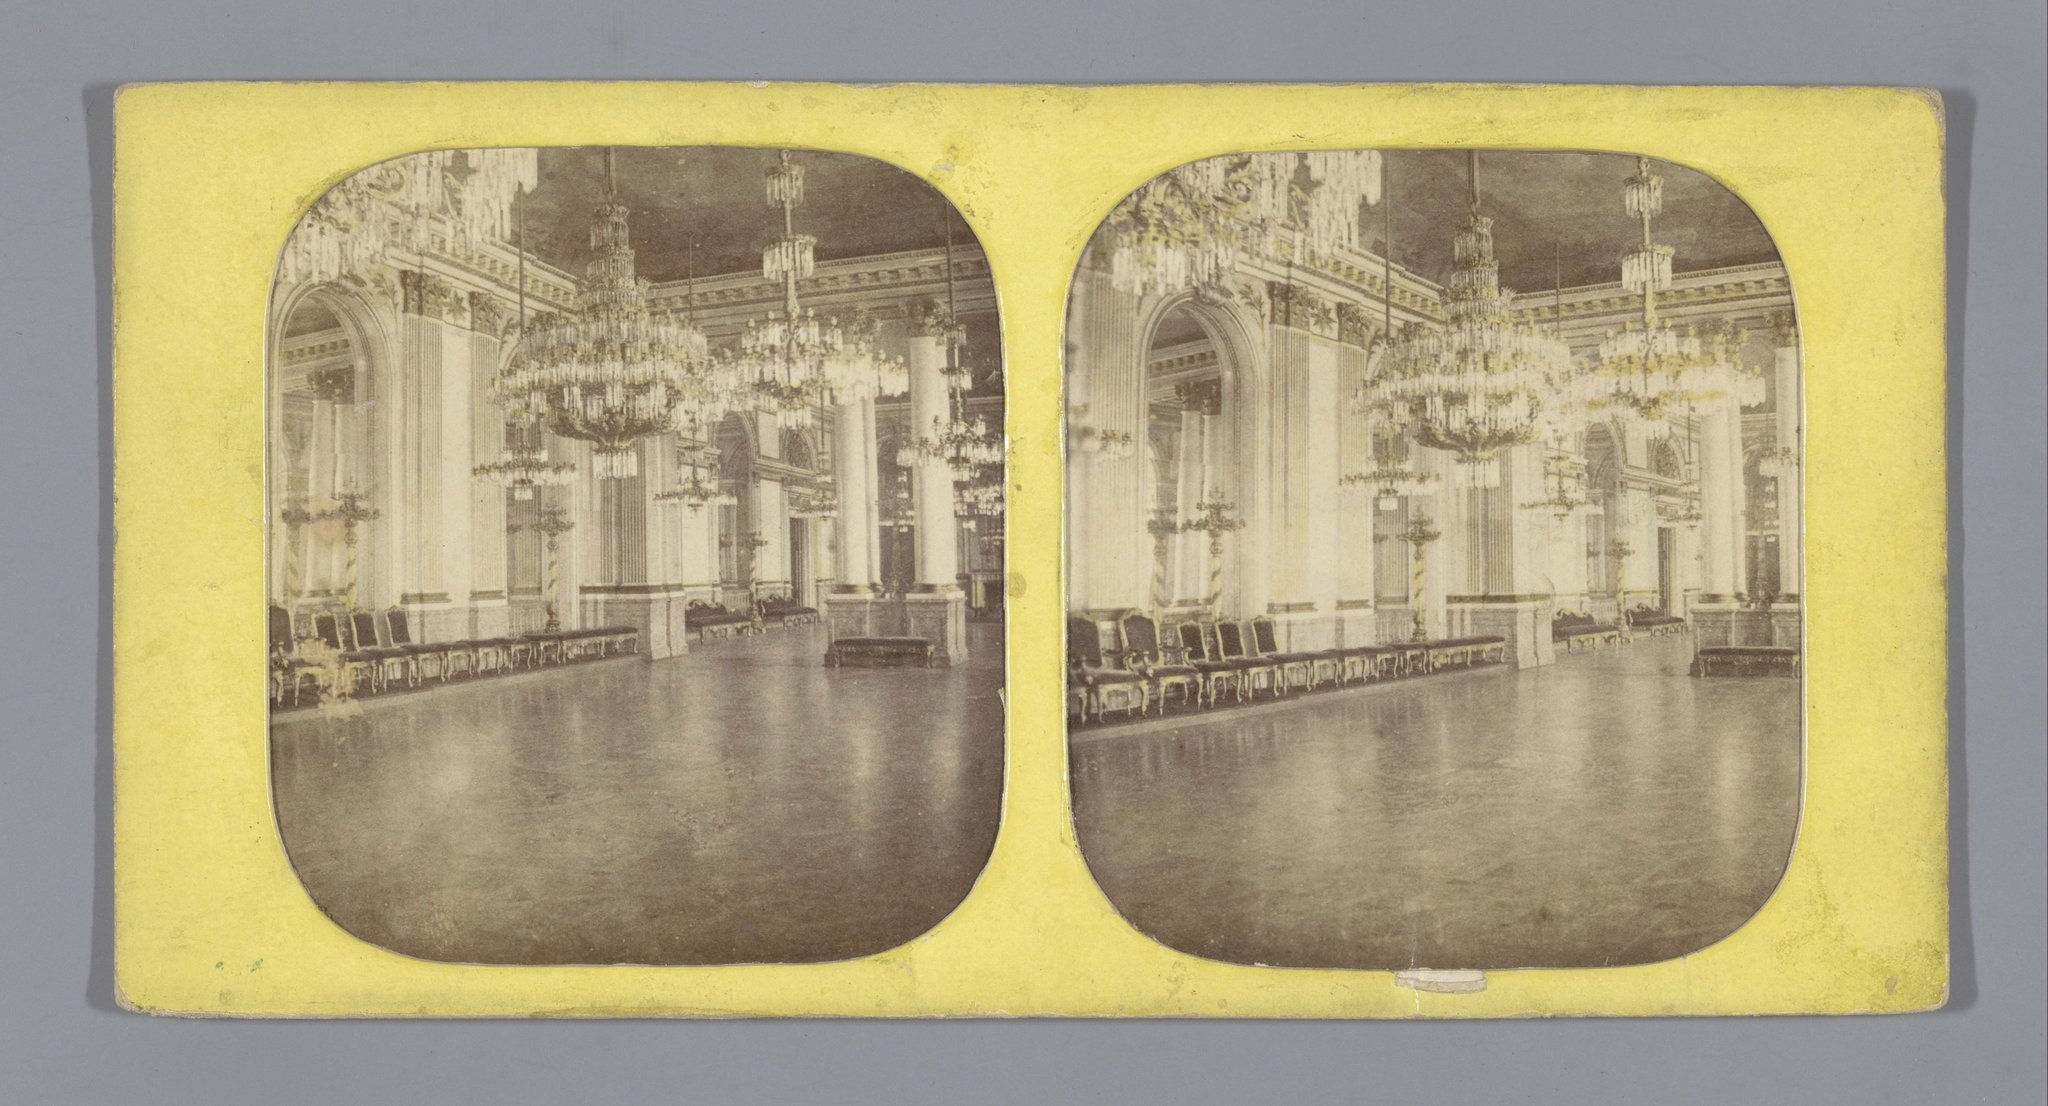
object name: tissue stereograph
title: De danszaal in het paleis te Stockholm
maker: johannes jaeger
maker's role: fotograaf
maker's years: 1832-1908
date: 1855-1875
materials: cardboard, paper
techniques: albumen print, hand coloring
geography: stockholm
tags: palace - aa - civic architecture: inside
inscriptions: stamp: ‘C’, inscription: ‘Vaita hafvet/ u Haugh Shottet [onz]’, inscription: ‘Kongl. Hof-Fotograf/ Stockholm’